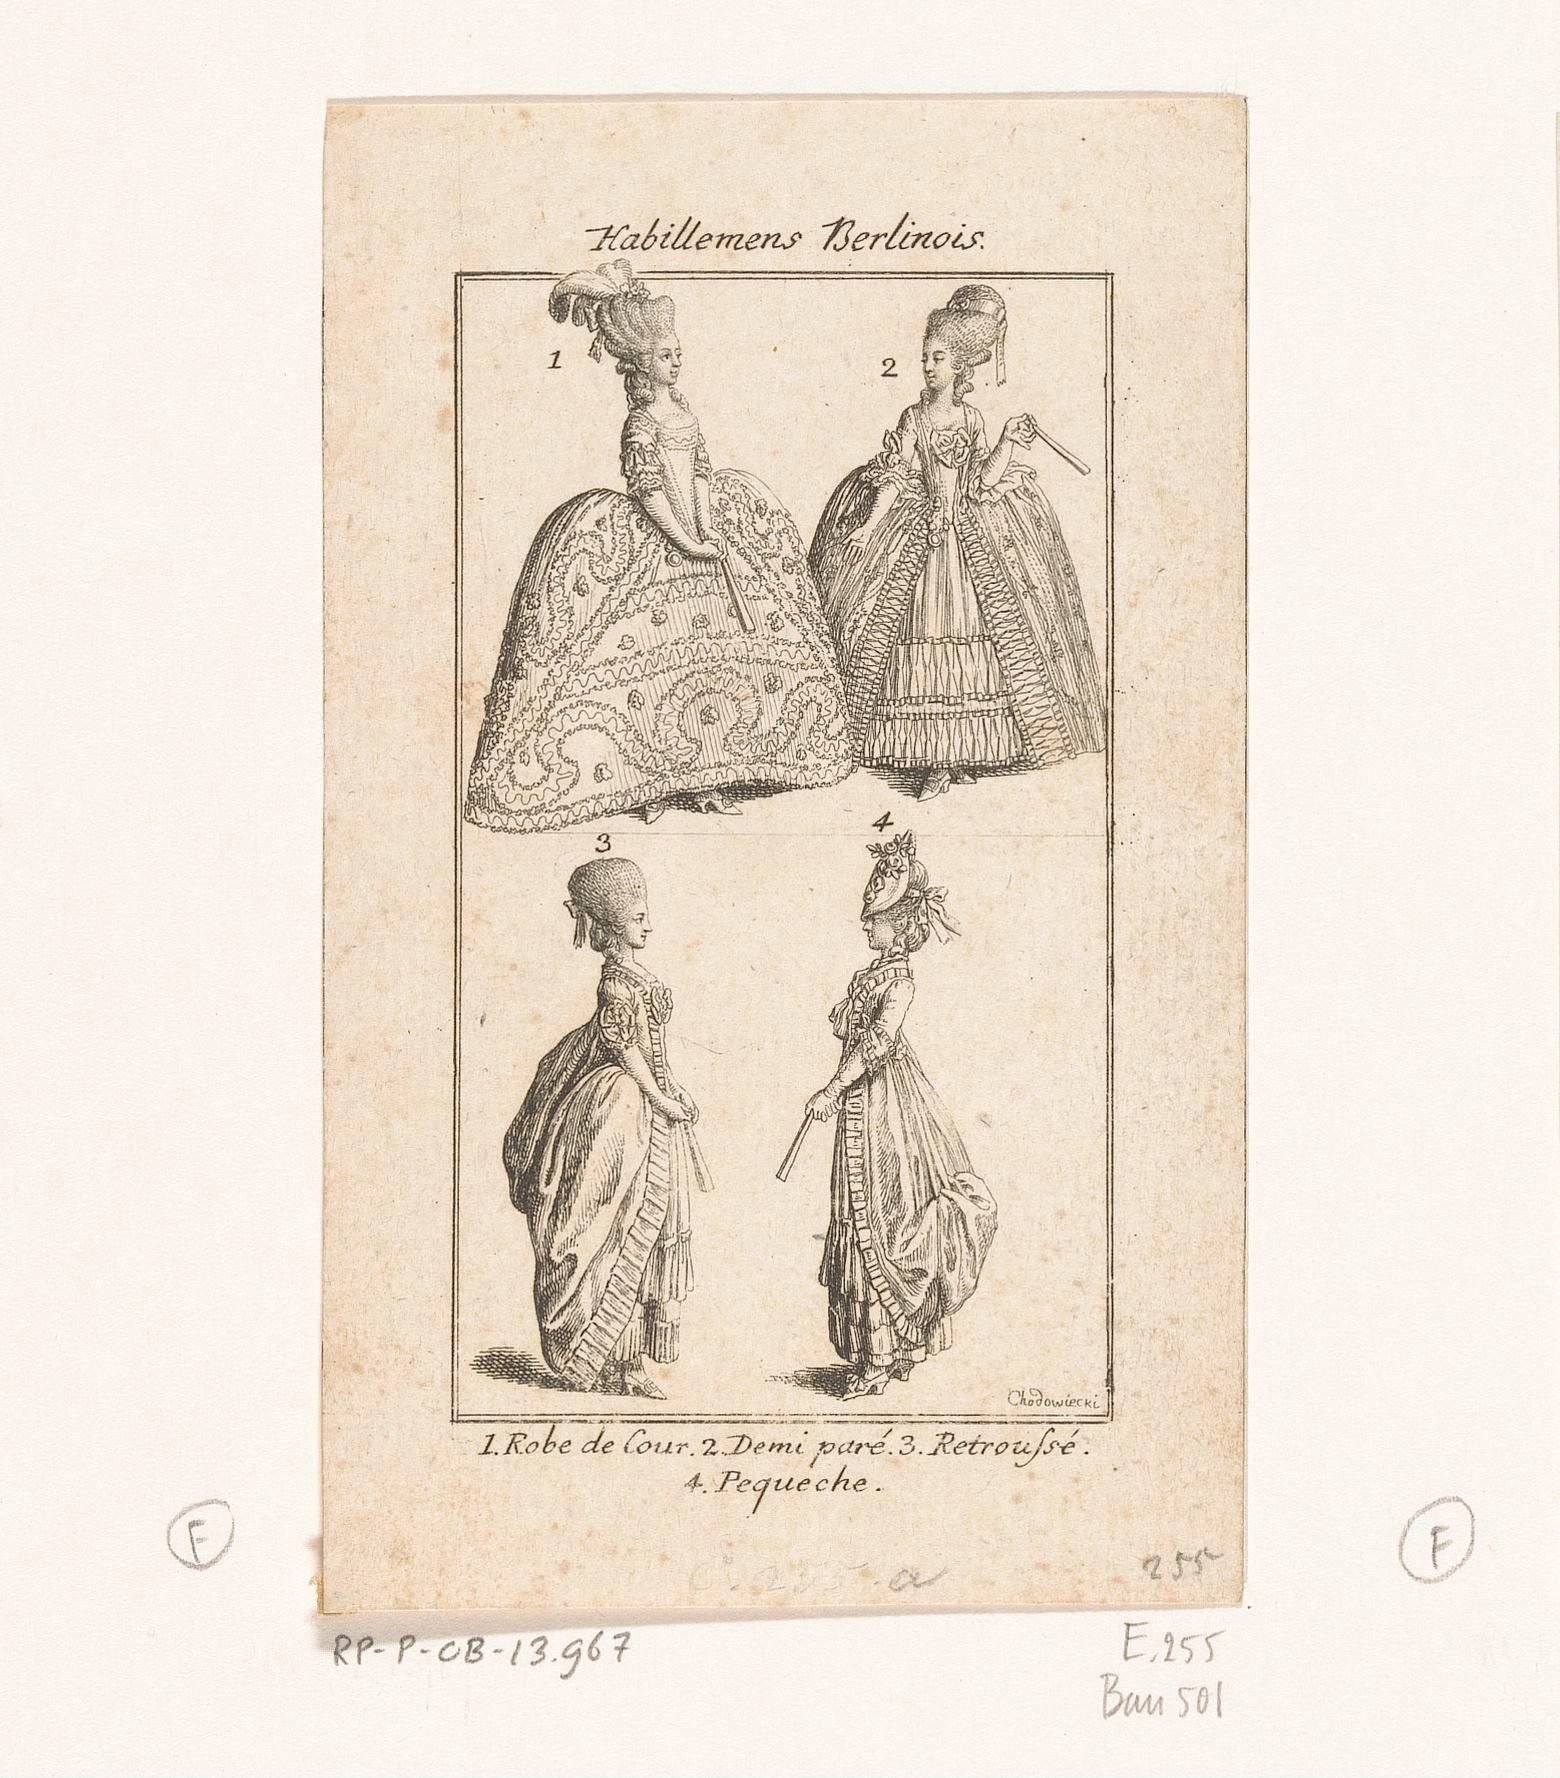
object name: print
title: Habillemens Berlinois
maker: daniel nikolaus chodowiecki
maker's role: draughtsman, print maker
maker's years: 1726-1801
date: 1778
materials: paper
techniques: etching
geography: berlin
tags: dress, gown: court gown or court dress (+ women's clothes), styles of hairdress - aa - ~ women, head-gear: hat (+ women's clothes), dress, gown (+ women's clothes)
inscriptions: collector's mark: Lugt 2228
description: Deze prent maakt deel uit van een serie van vijf voorstellingen met mode en haardrecht. Deze voorstellingen werden samen op een plaat geëtst. Deze prent is ook gebruikt in: Königl. Grossbr. u. Churf. Braunschw. Lüneb. Genealogischer Kalender auf das Jahr 1779. Lauenburg, J.G. Berenberg.